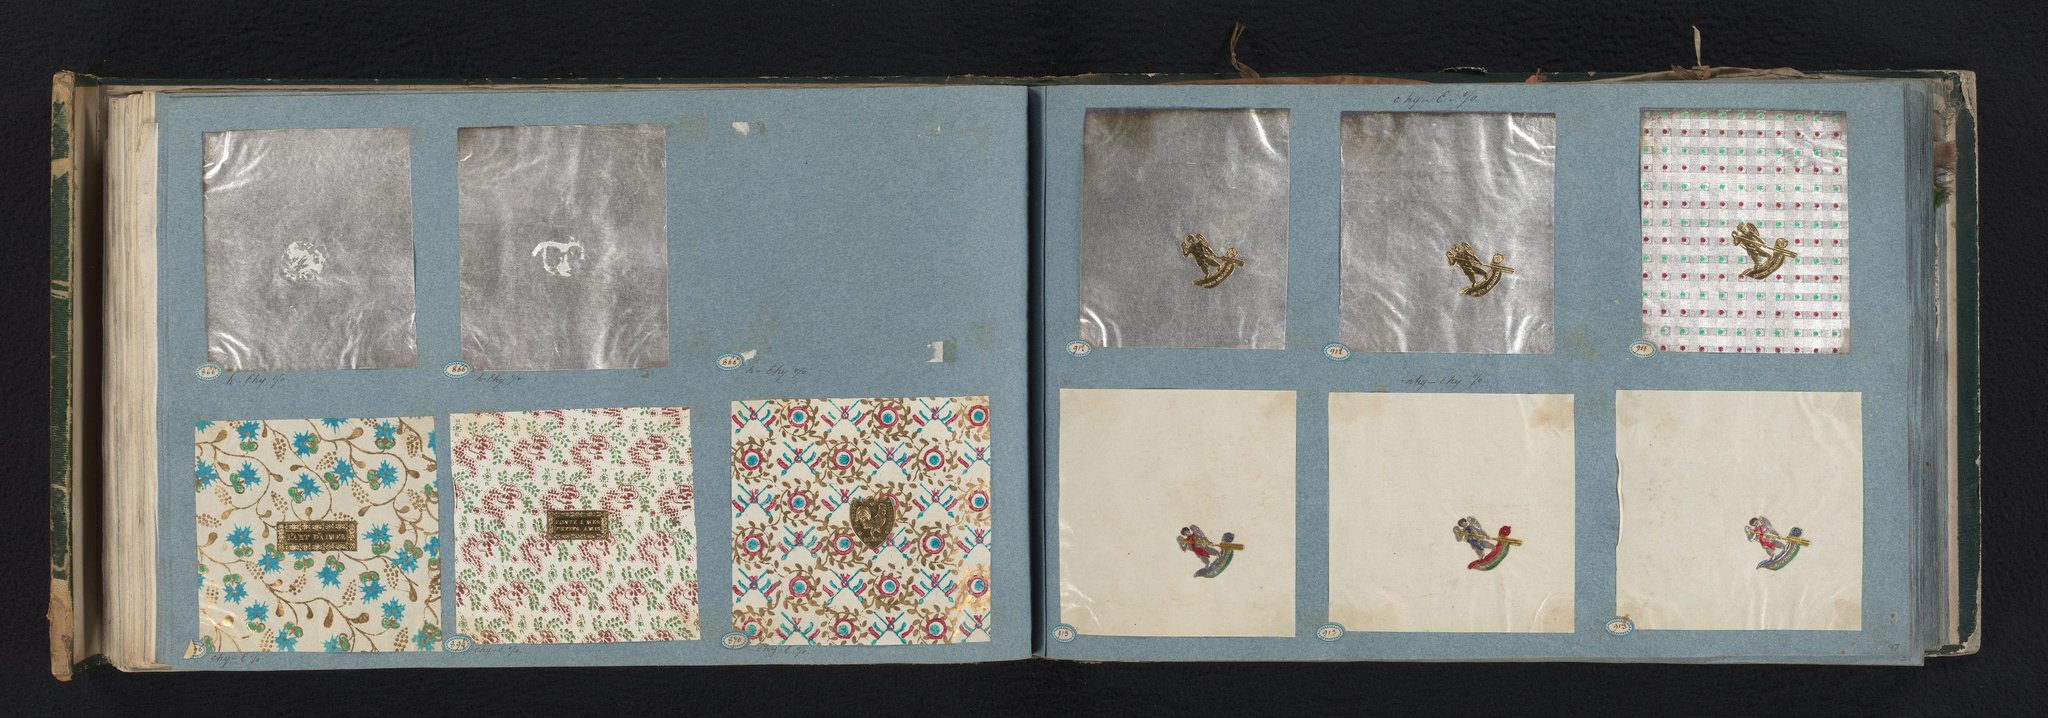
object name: printed paper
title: Twee bladzijden met stalen van sitspapier en metaalpapier met goudkleurige labels en vignetten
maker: Anonymous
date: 1830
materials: gold leaf, ink, paper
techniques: printing block, manufacturing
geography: france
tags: ornaments ~ art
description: Twee bladzijden met 11 opgeplakte stalen van sitspapier en zilverkleurig metaalpapier met labels met Franse teksten in goudkleurig metaalpapier en goudkleurige en ingekleurde vignetten. Eén van de stalen (nr. 866) ontbreekt. Alle stalen voorzien van etiketten met nummers (866-913) en handgeschreven codes. Onderdeel van het stalenboek geschonken door de dames Van Rijn, vermoedelijk van een Franse papierfabrikant van luxe papieren, of diens vertegenwoordiger in Nederland, ca. 1830.